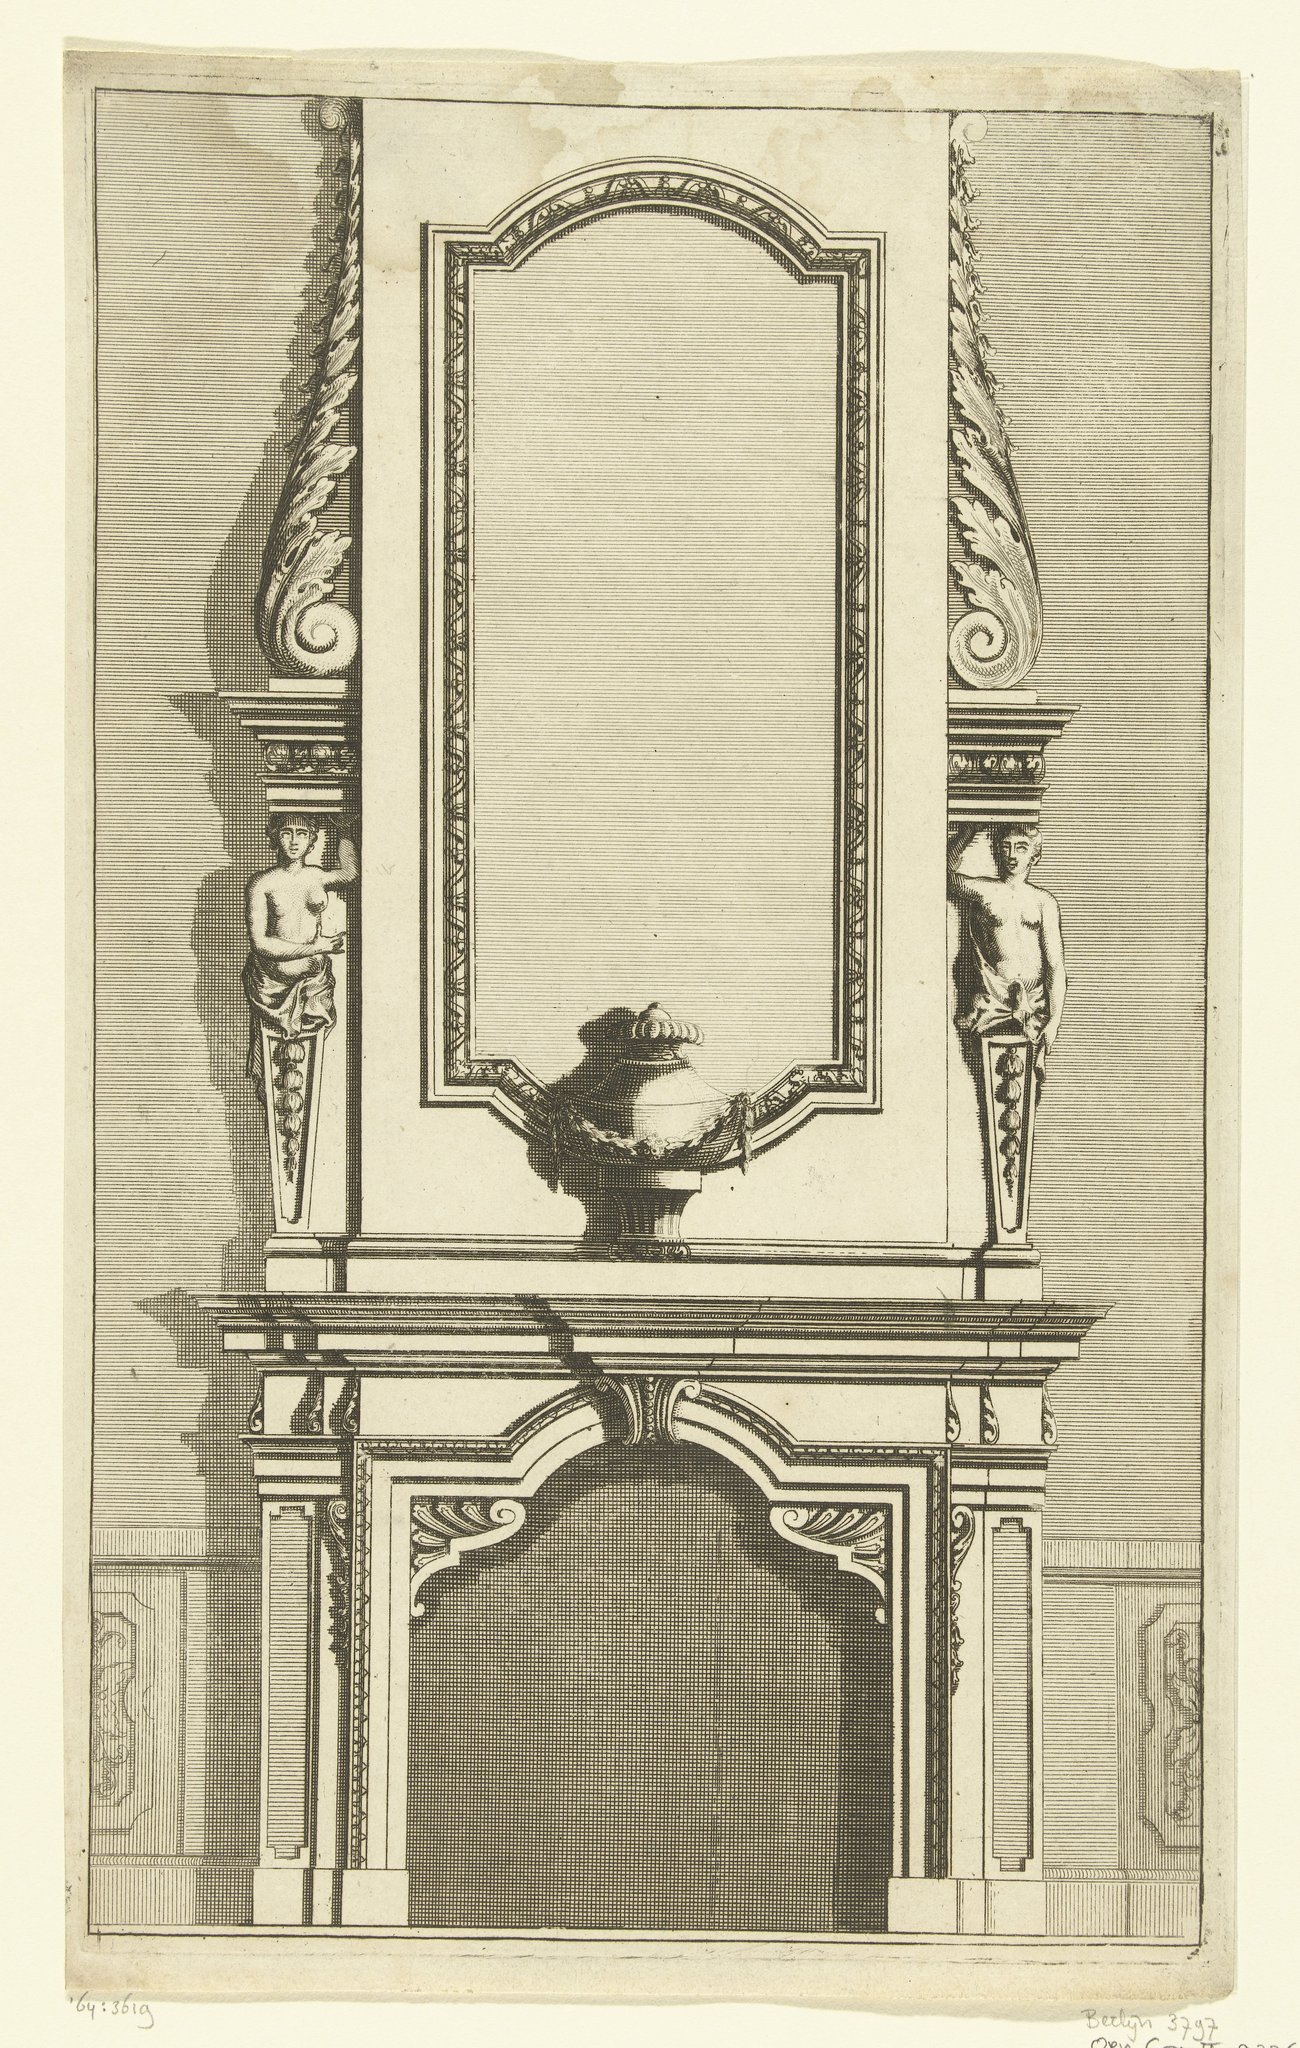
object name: print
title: Onderboezem met twee hermen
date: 1680-1700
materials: paper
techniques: etching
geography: amsterdam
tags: herm: pillar with the head of mercury, patron of travellers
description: Onderaan de spiegel staat een urn. Aan weerszijden daarvan staat een herme.